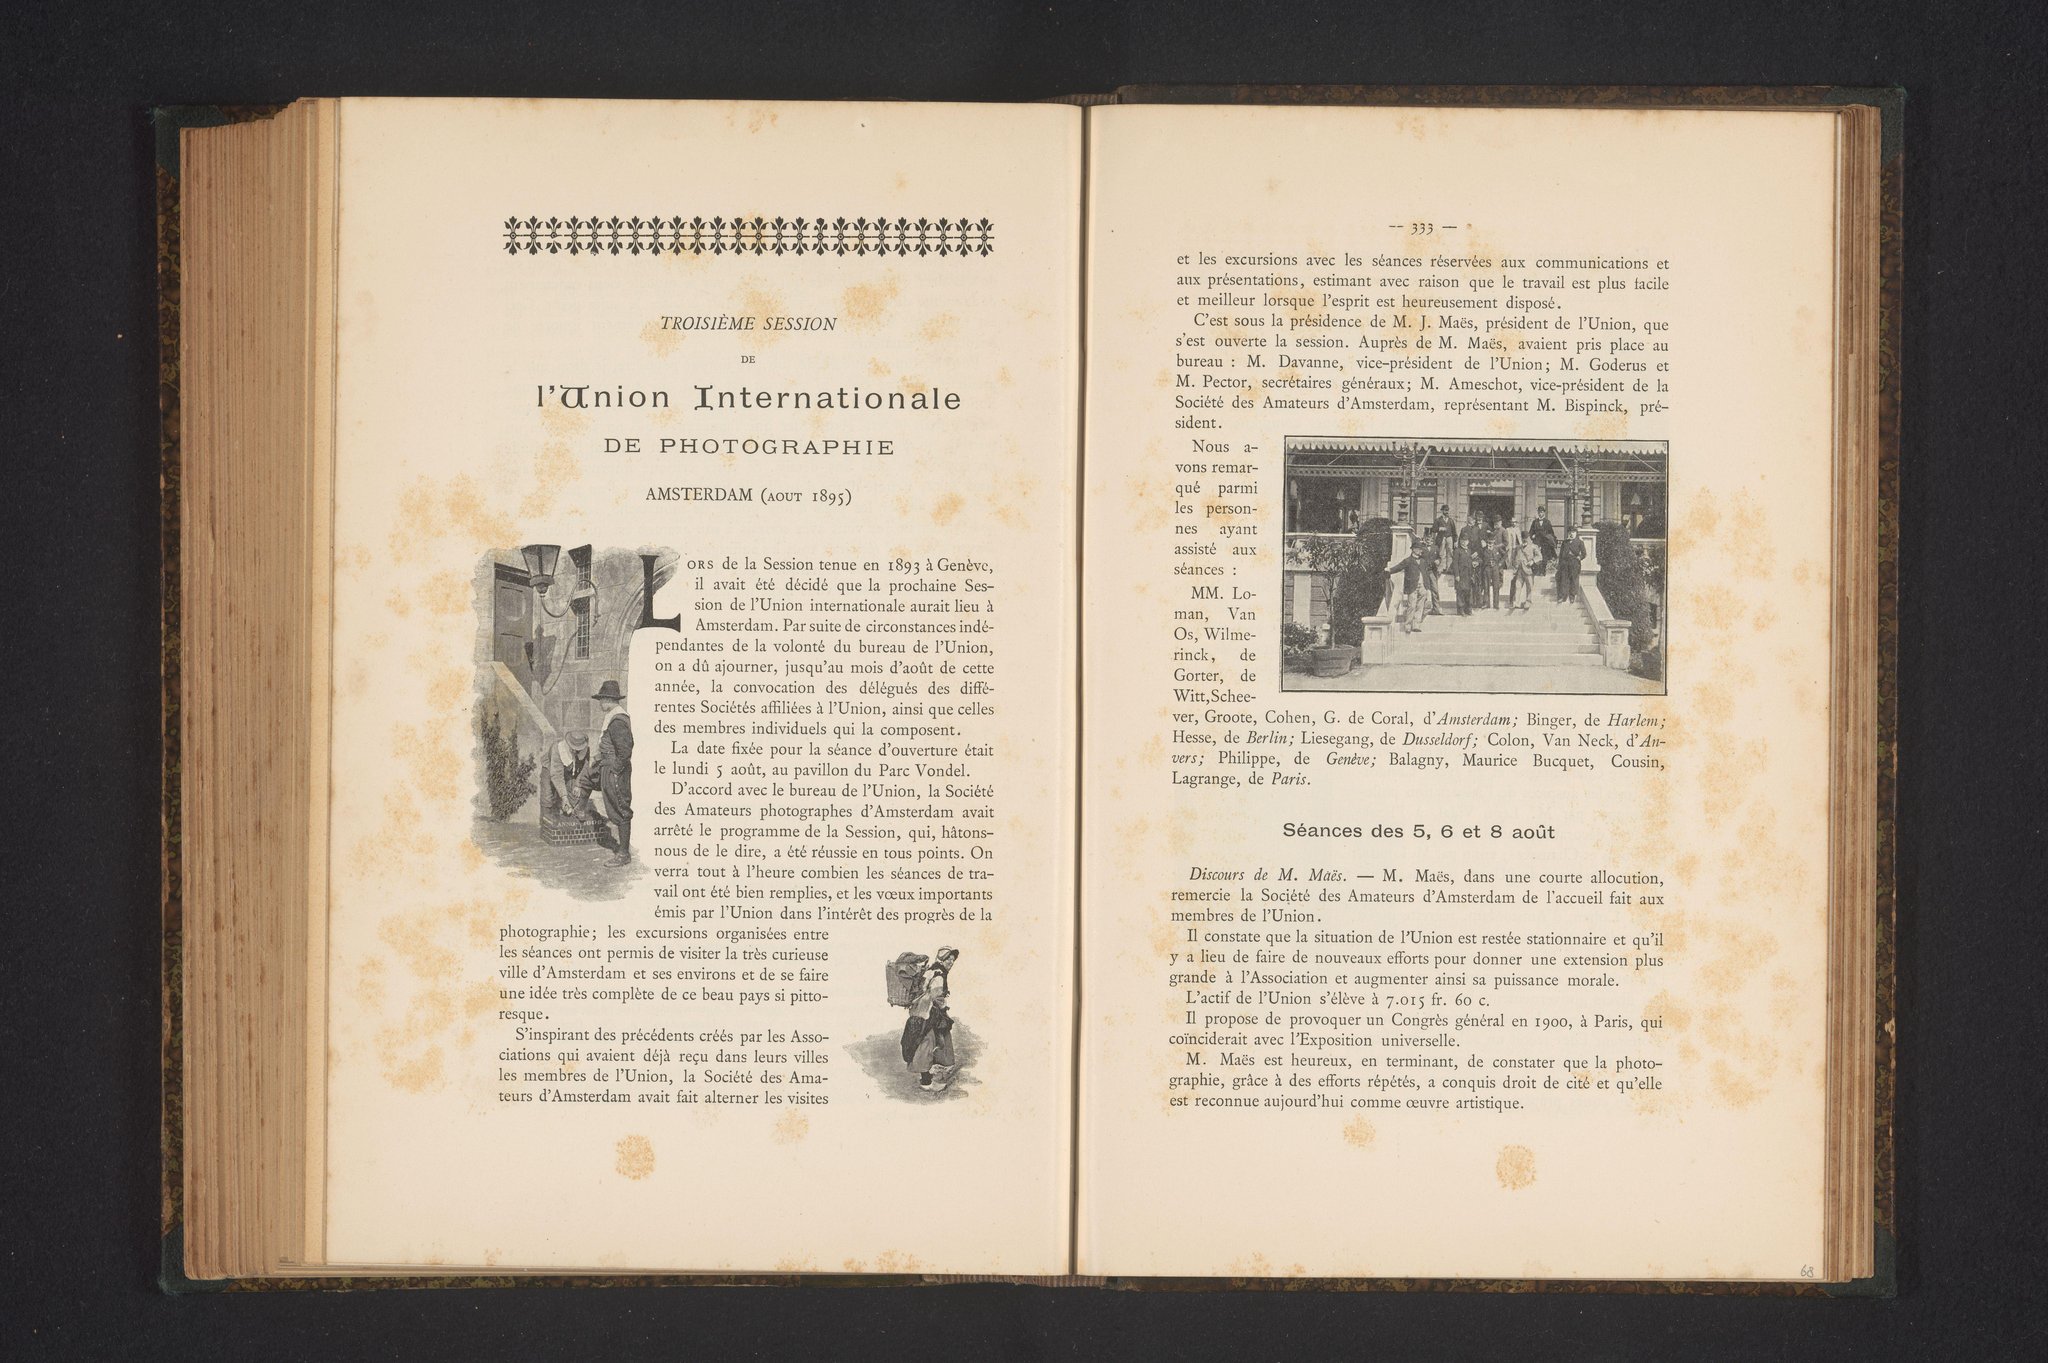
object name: photomechanical print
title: Groepsportret van de Union Internationale de Photographie van 1895 in het Vondelpark, Amsterdam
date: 1895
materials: paper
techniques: autotype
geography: vondelpark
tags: anonymous historical persons portrayed in a group, in a group-portrait